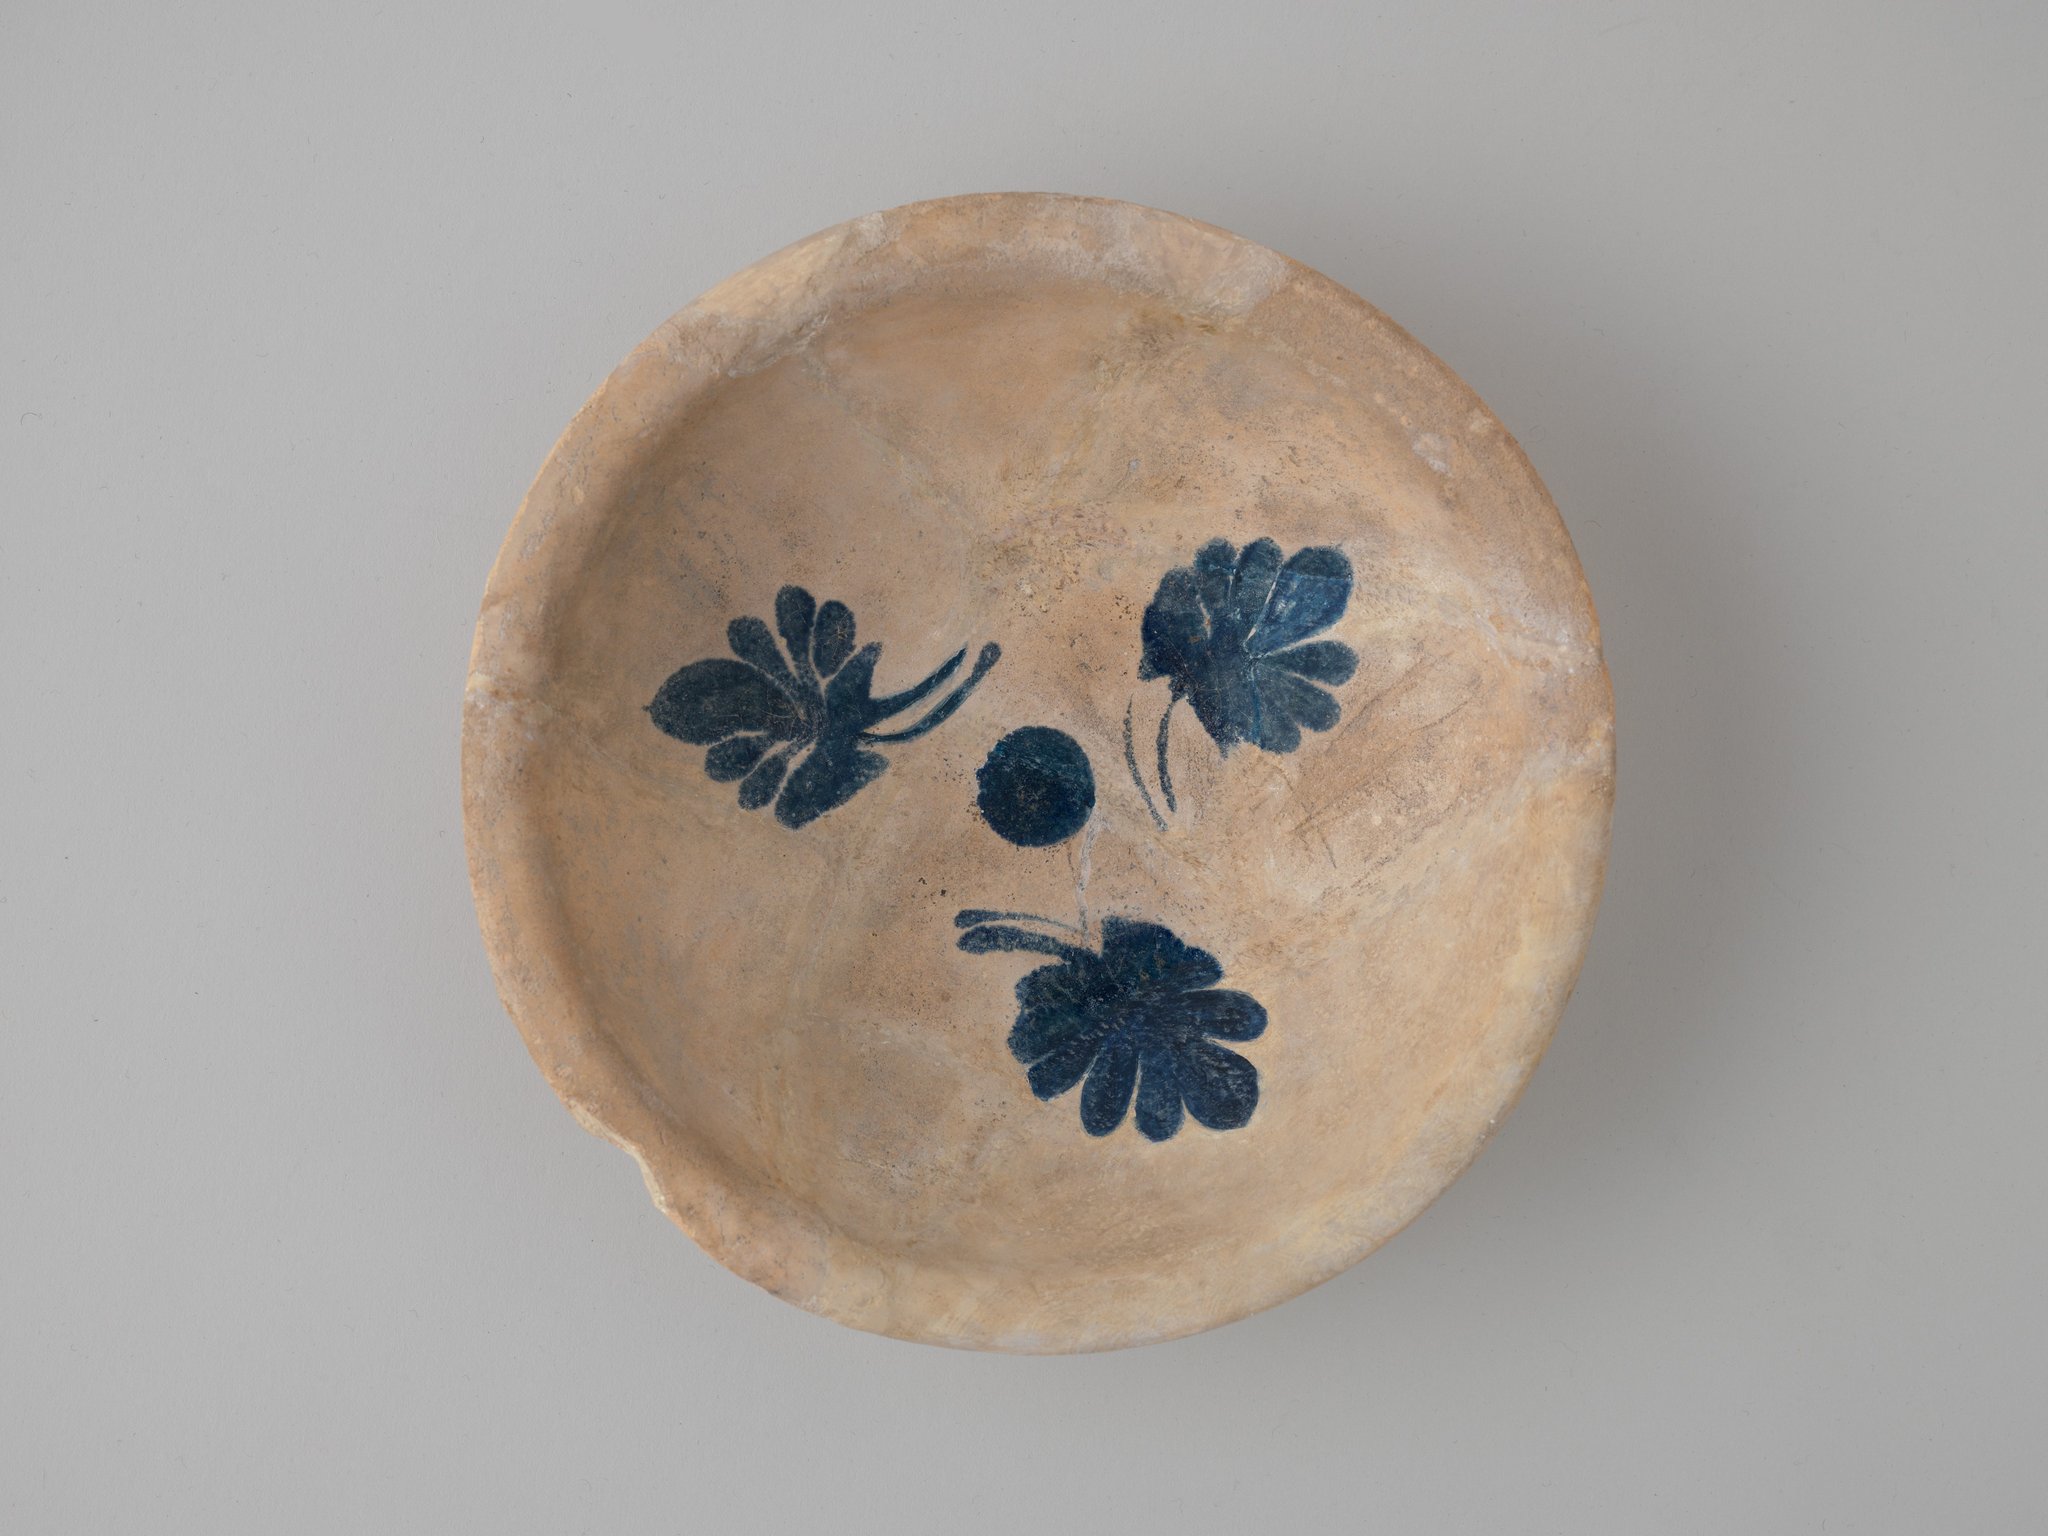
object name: bowl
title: Imported Cobalt-on-White Bowl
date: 801-1000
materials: earthenware, glaze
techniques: painting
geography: iraq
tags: leaves